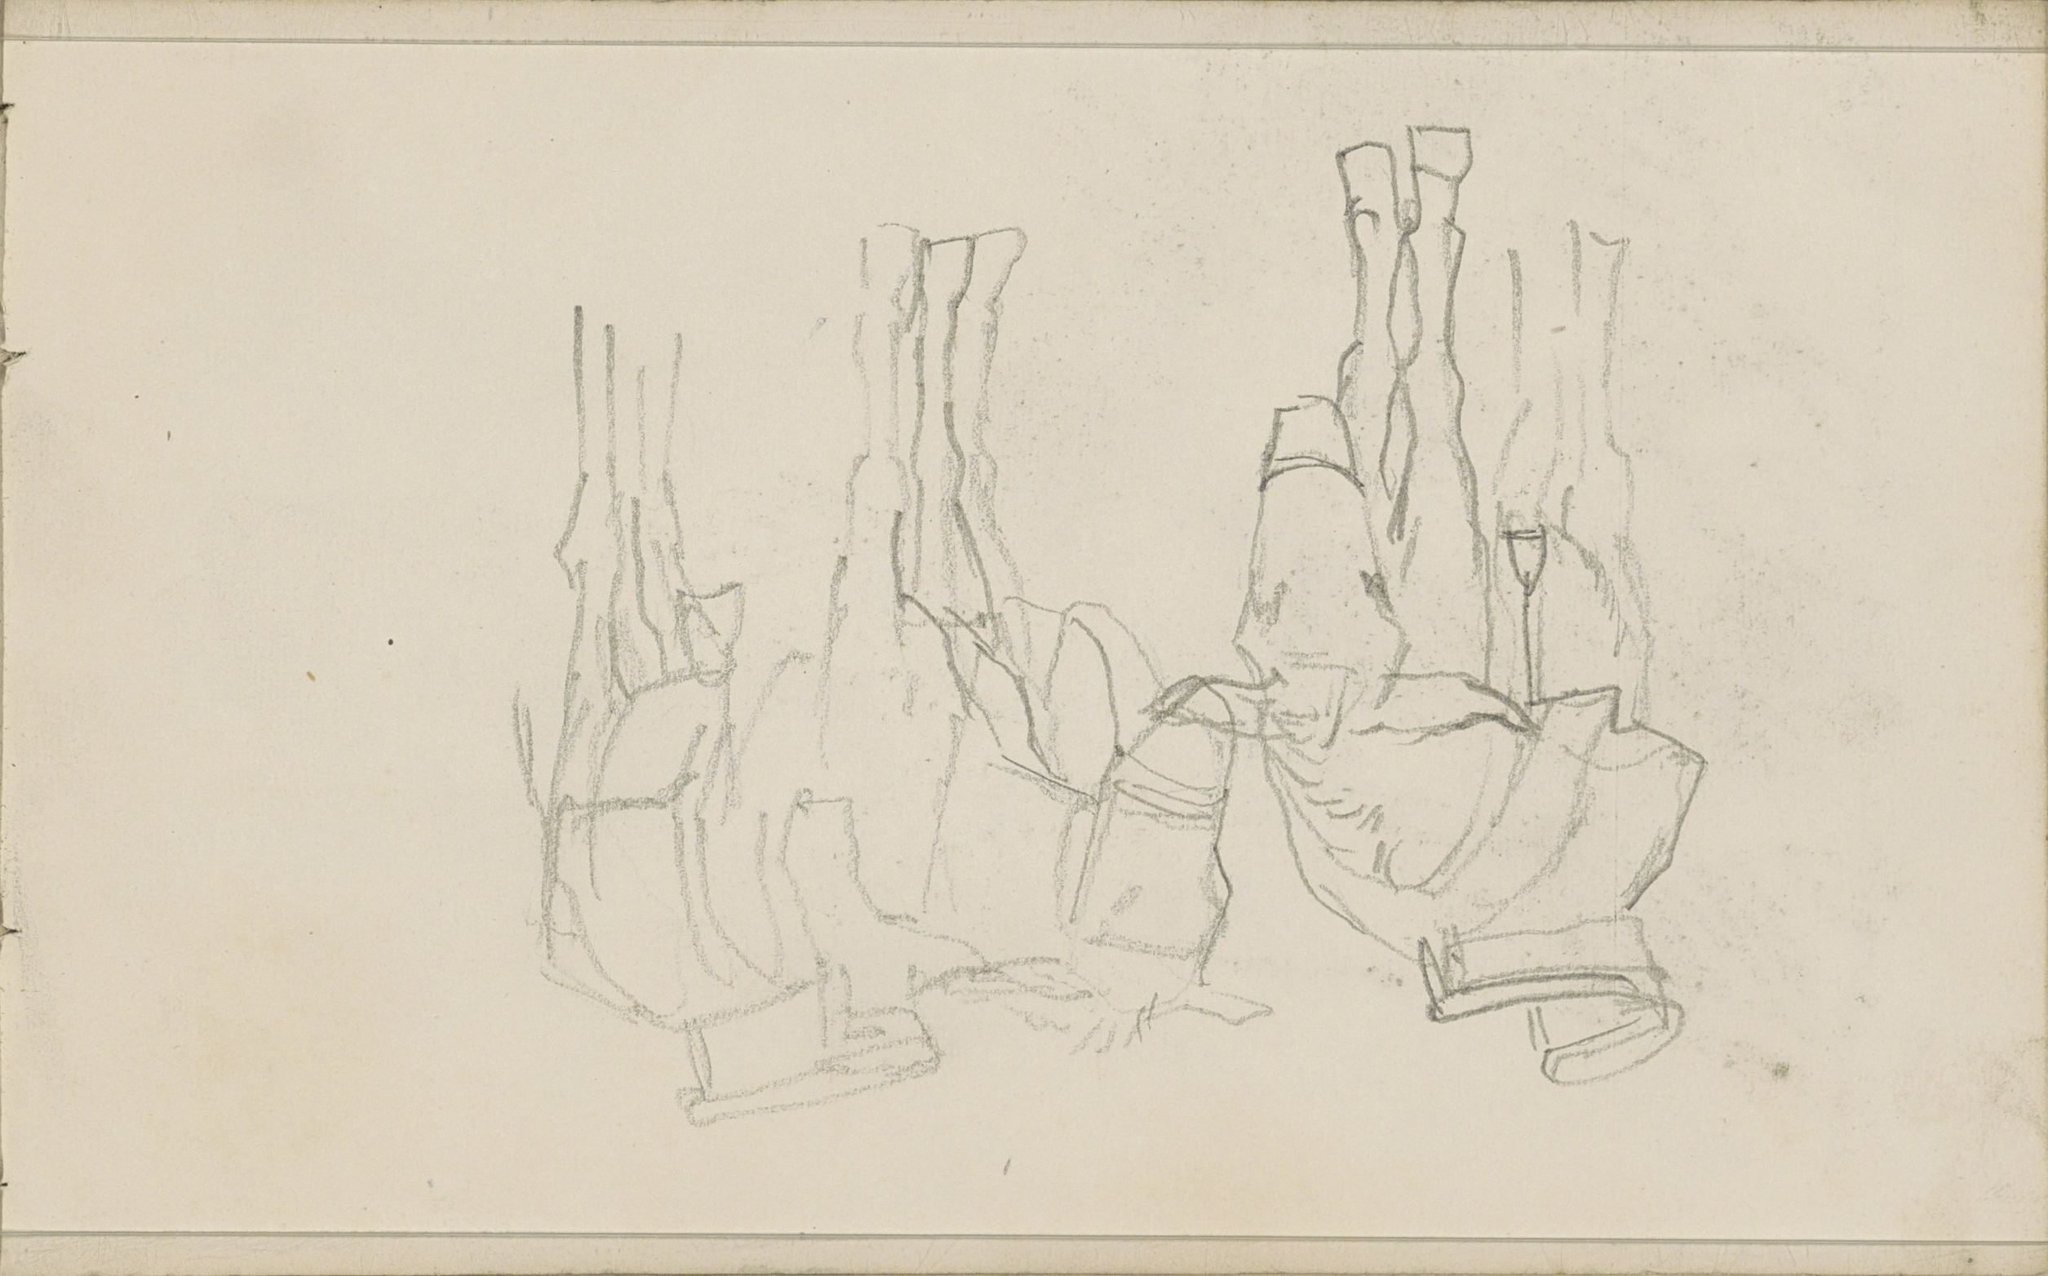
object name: sketchbook leaf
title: Twee gezadelde en bepakte ezels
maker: anton mauve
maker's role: draughtsman, painter, print maker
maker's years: 1838-1888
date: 1848-1888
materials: paper, pencil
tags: ass, donkey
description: Blad 19 recto uit een schetsboek met 42 bladen.